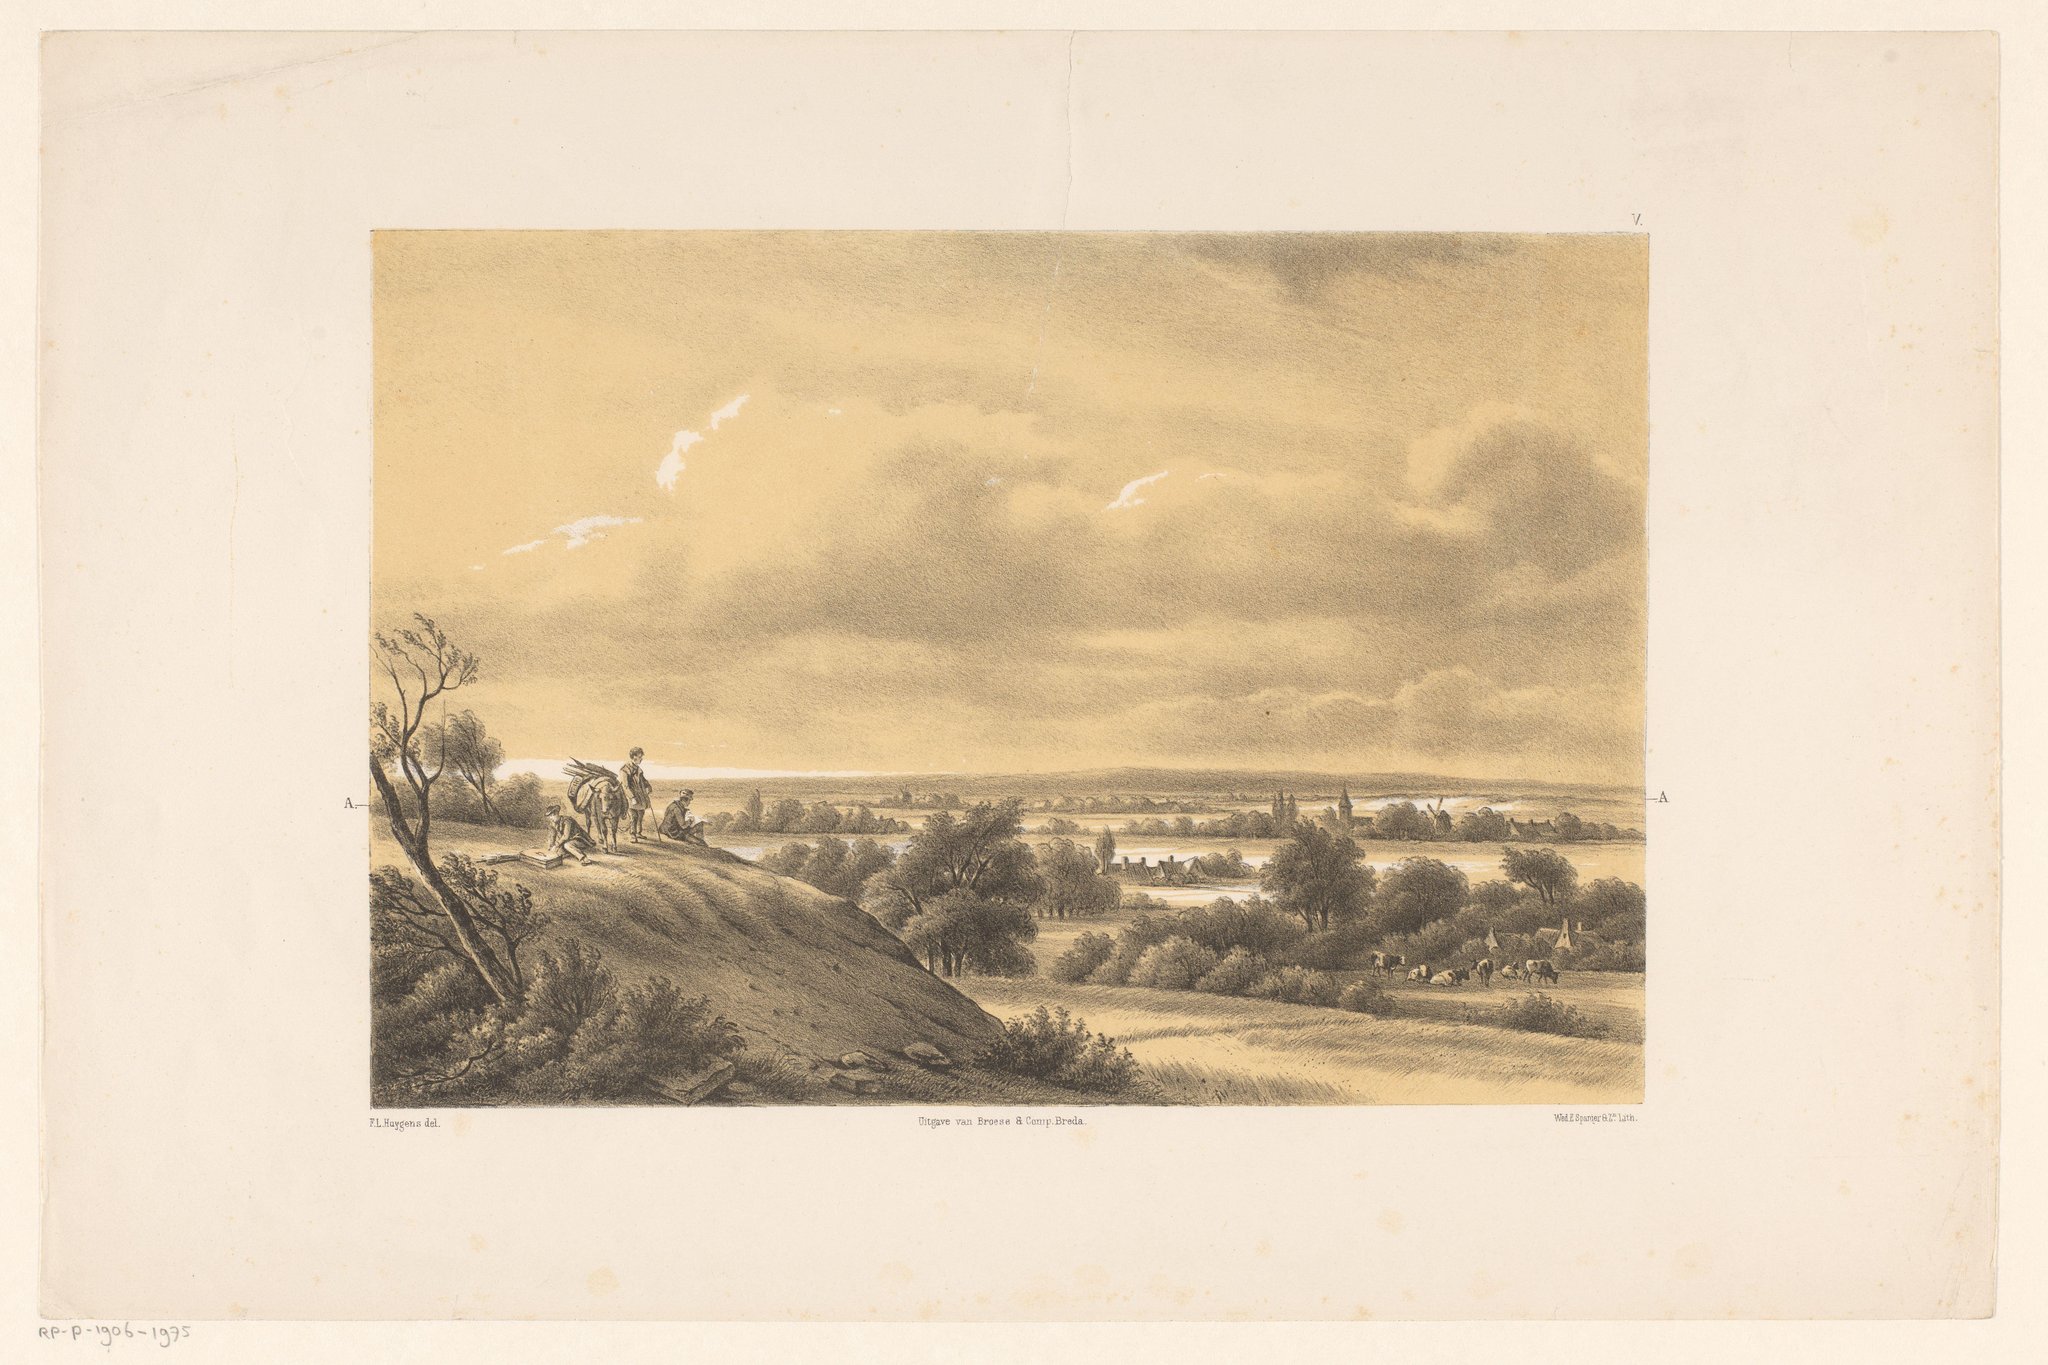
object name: print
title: Tekenaars in een landschap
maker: frederik lodewijk huygens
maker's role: draughtsman, print maker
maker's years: 1802-1887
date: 1863-1883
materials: paper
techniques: tone lithography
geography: netherlands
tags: landscapes in the temperate zone, draughtsman at work - cc - out of doors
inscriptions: collector's mark: Lugt 2228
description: Links een groepje mannen op een heuvel. Zij hebben een bepakte ezel en tekenspullen bij zich. Ze kijken uit over een landschap met bomen, huizen en koeien. Genummerd rechtsboven: V. Links en rechts, ter hoogte van de horizon, de letters 'A'.